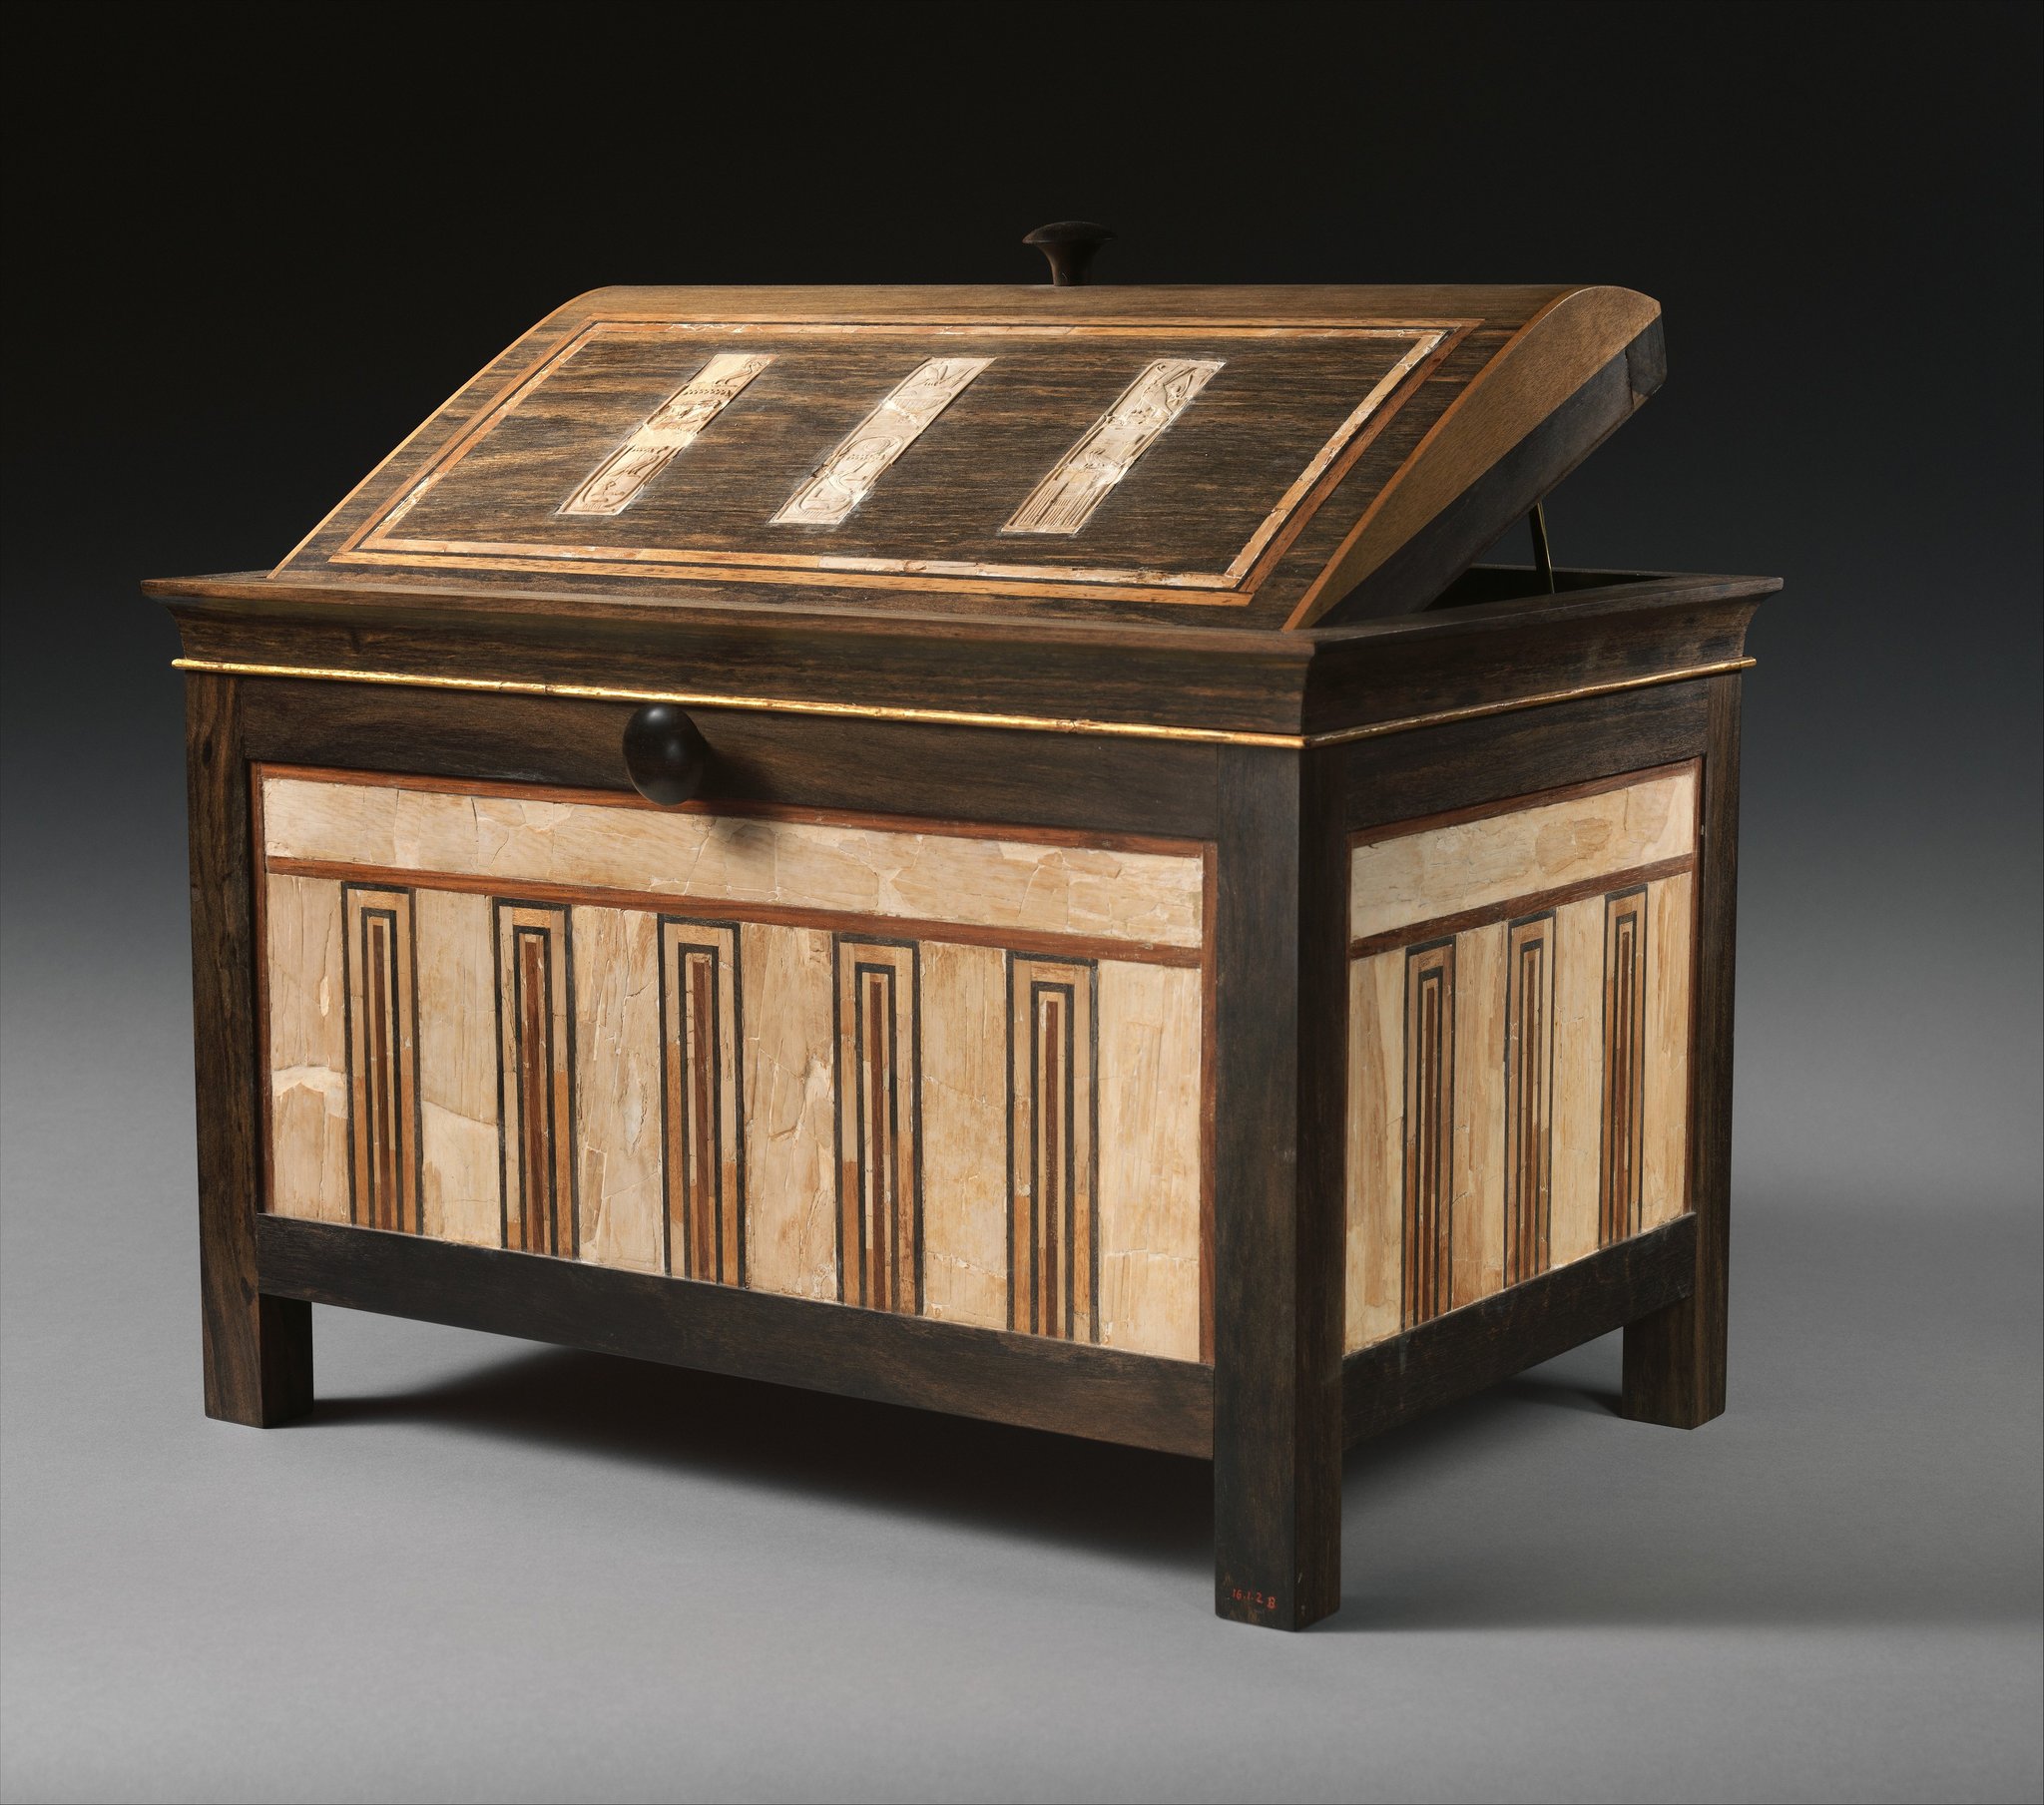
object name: box, sithathoryunet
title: Inlaid box for cosmetic vessels of Sithathoryunet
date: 1887-1813 BCE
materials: wood, gold, ivory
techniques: inlay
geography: egypt